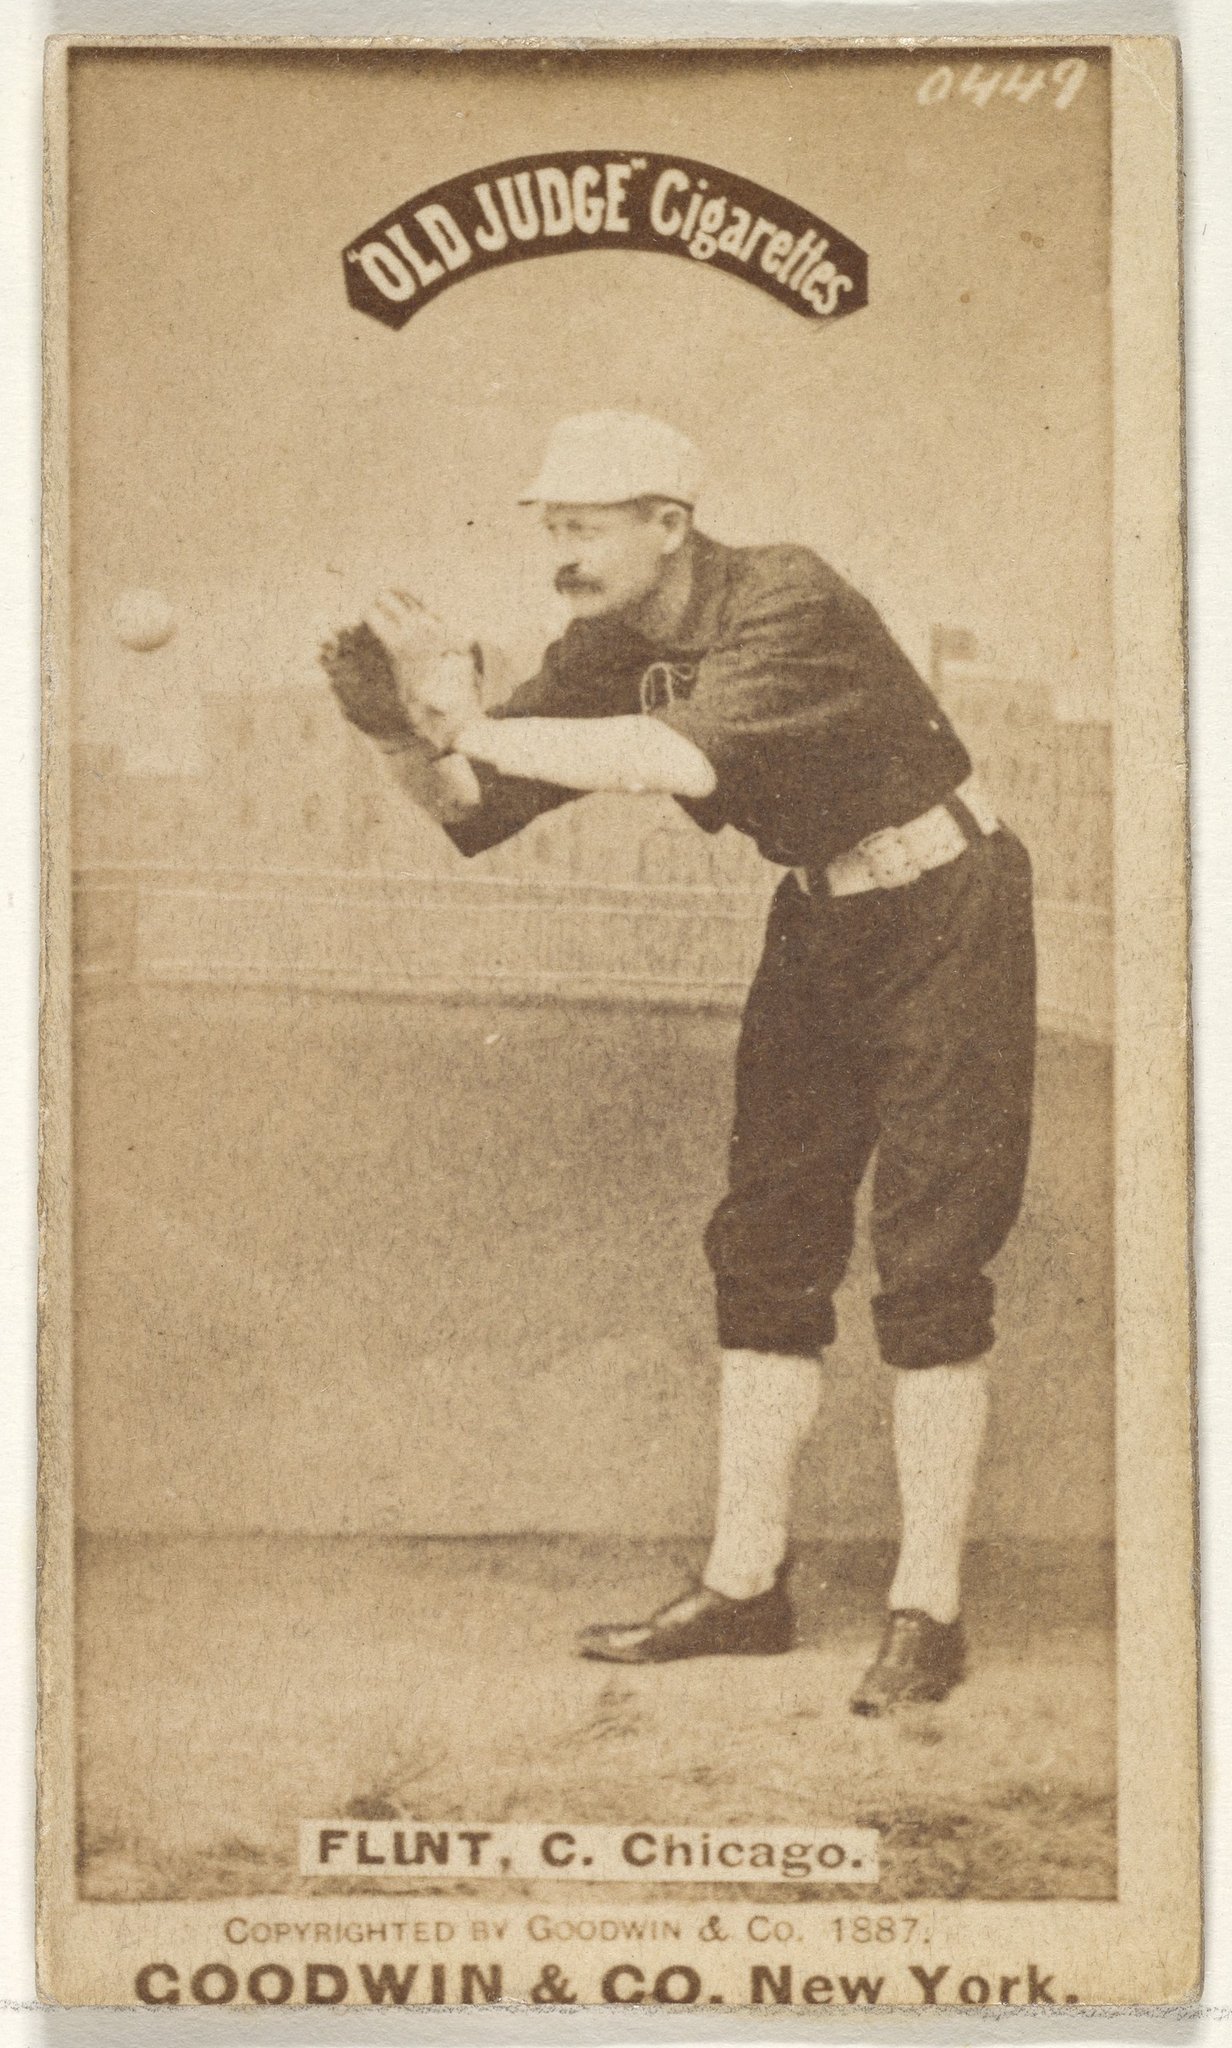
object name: baseball card, photograph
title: Frank Sylvester "Silver" Flint, Catcher, Chicago, from the Old Judge series (N172) for Old Judge Cigarettes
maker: goodwin & company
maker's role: publisher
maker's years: 1850-1950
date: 1887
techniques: albumen silver print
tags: men,portraits,baseball,athletes